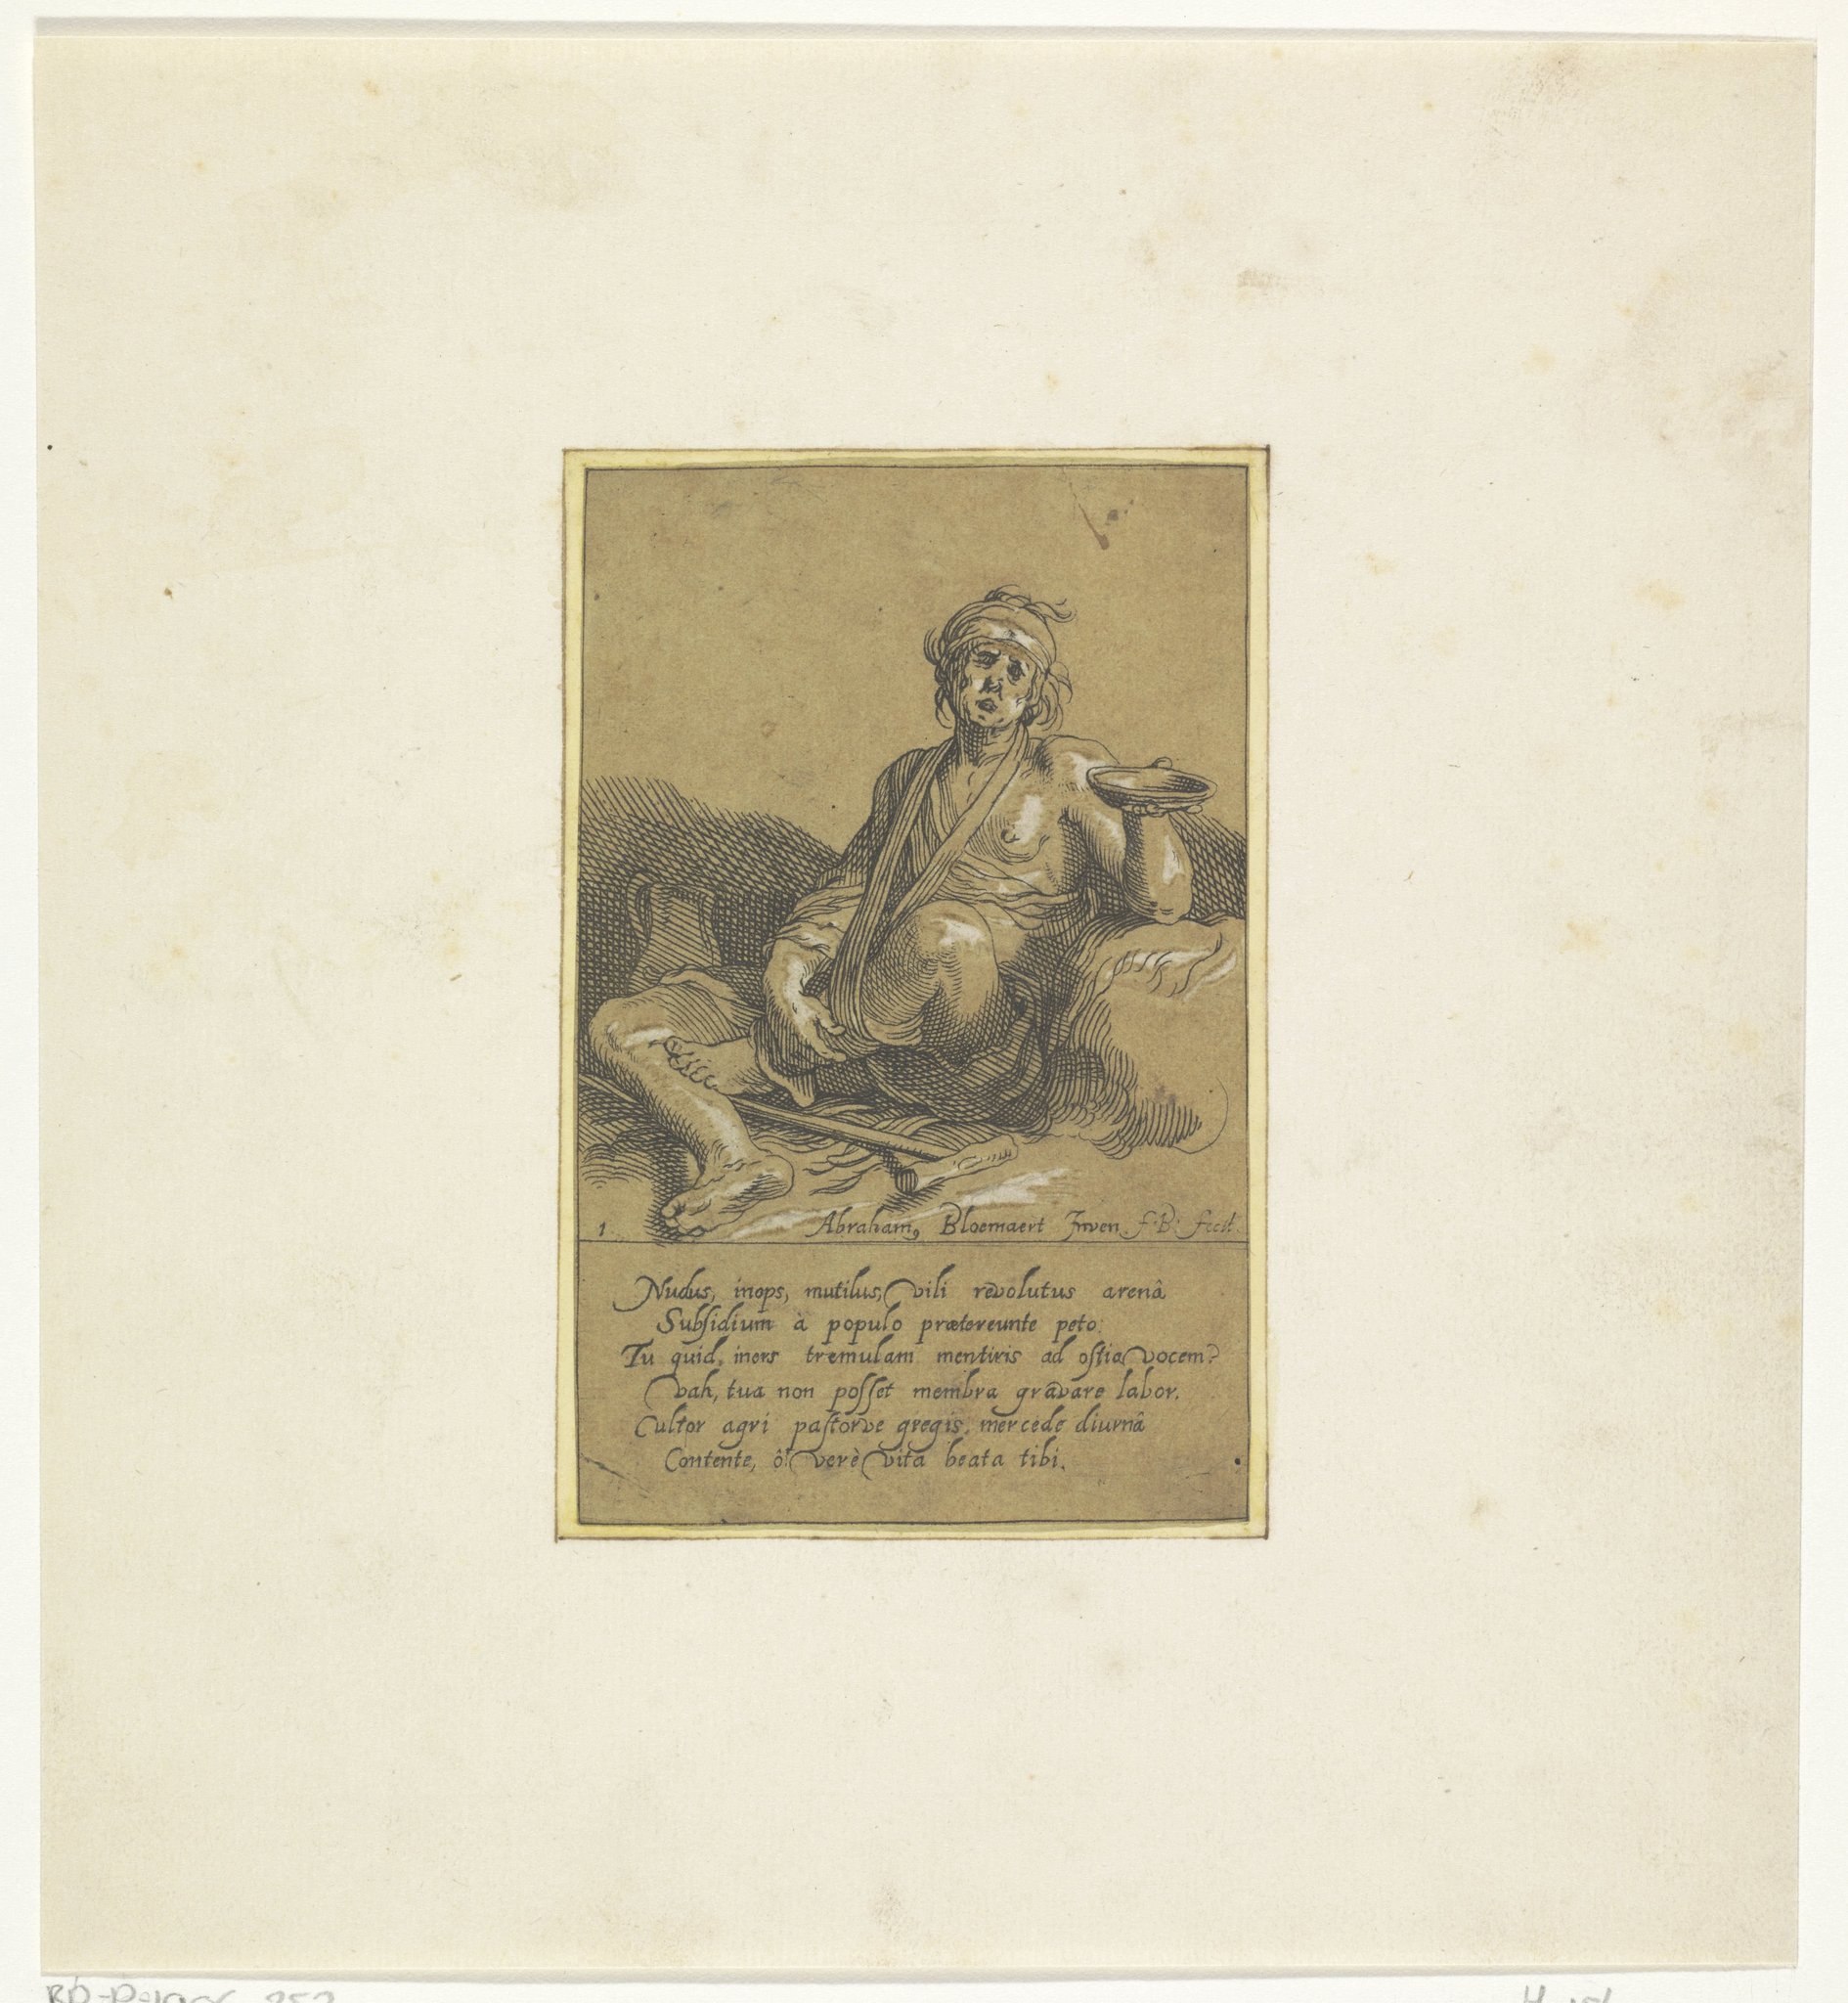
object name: print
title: Kleine figuren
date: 1635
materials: paper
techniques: woodcut, etching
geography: utrecht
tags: disabilities, deformations, beggar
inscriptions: collector's mark: Lugt 2228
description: In de ondermarge zes regels Latijnse tekst. Linksonder het getal '1'.